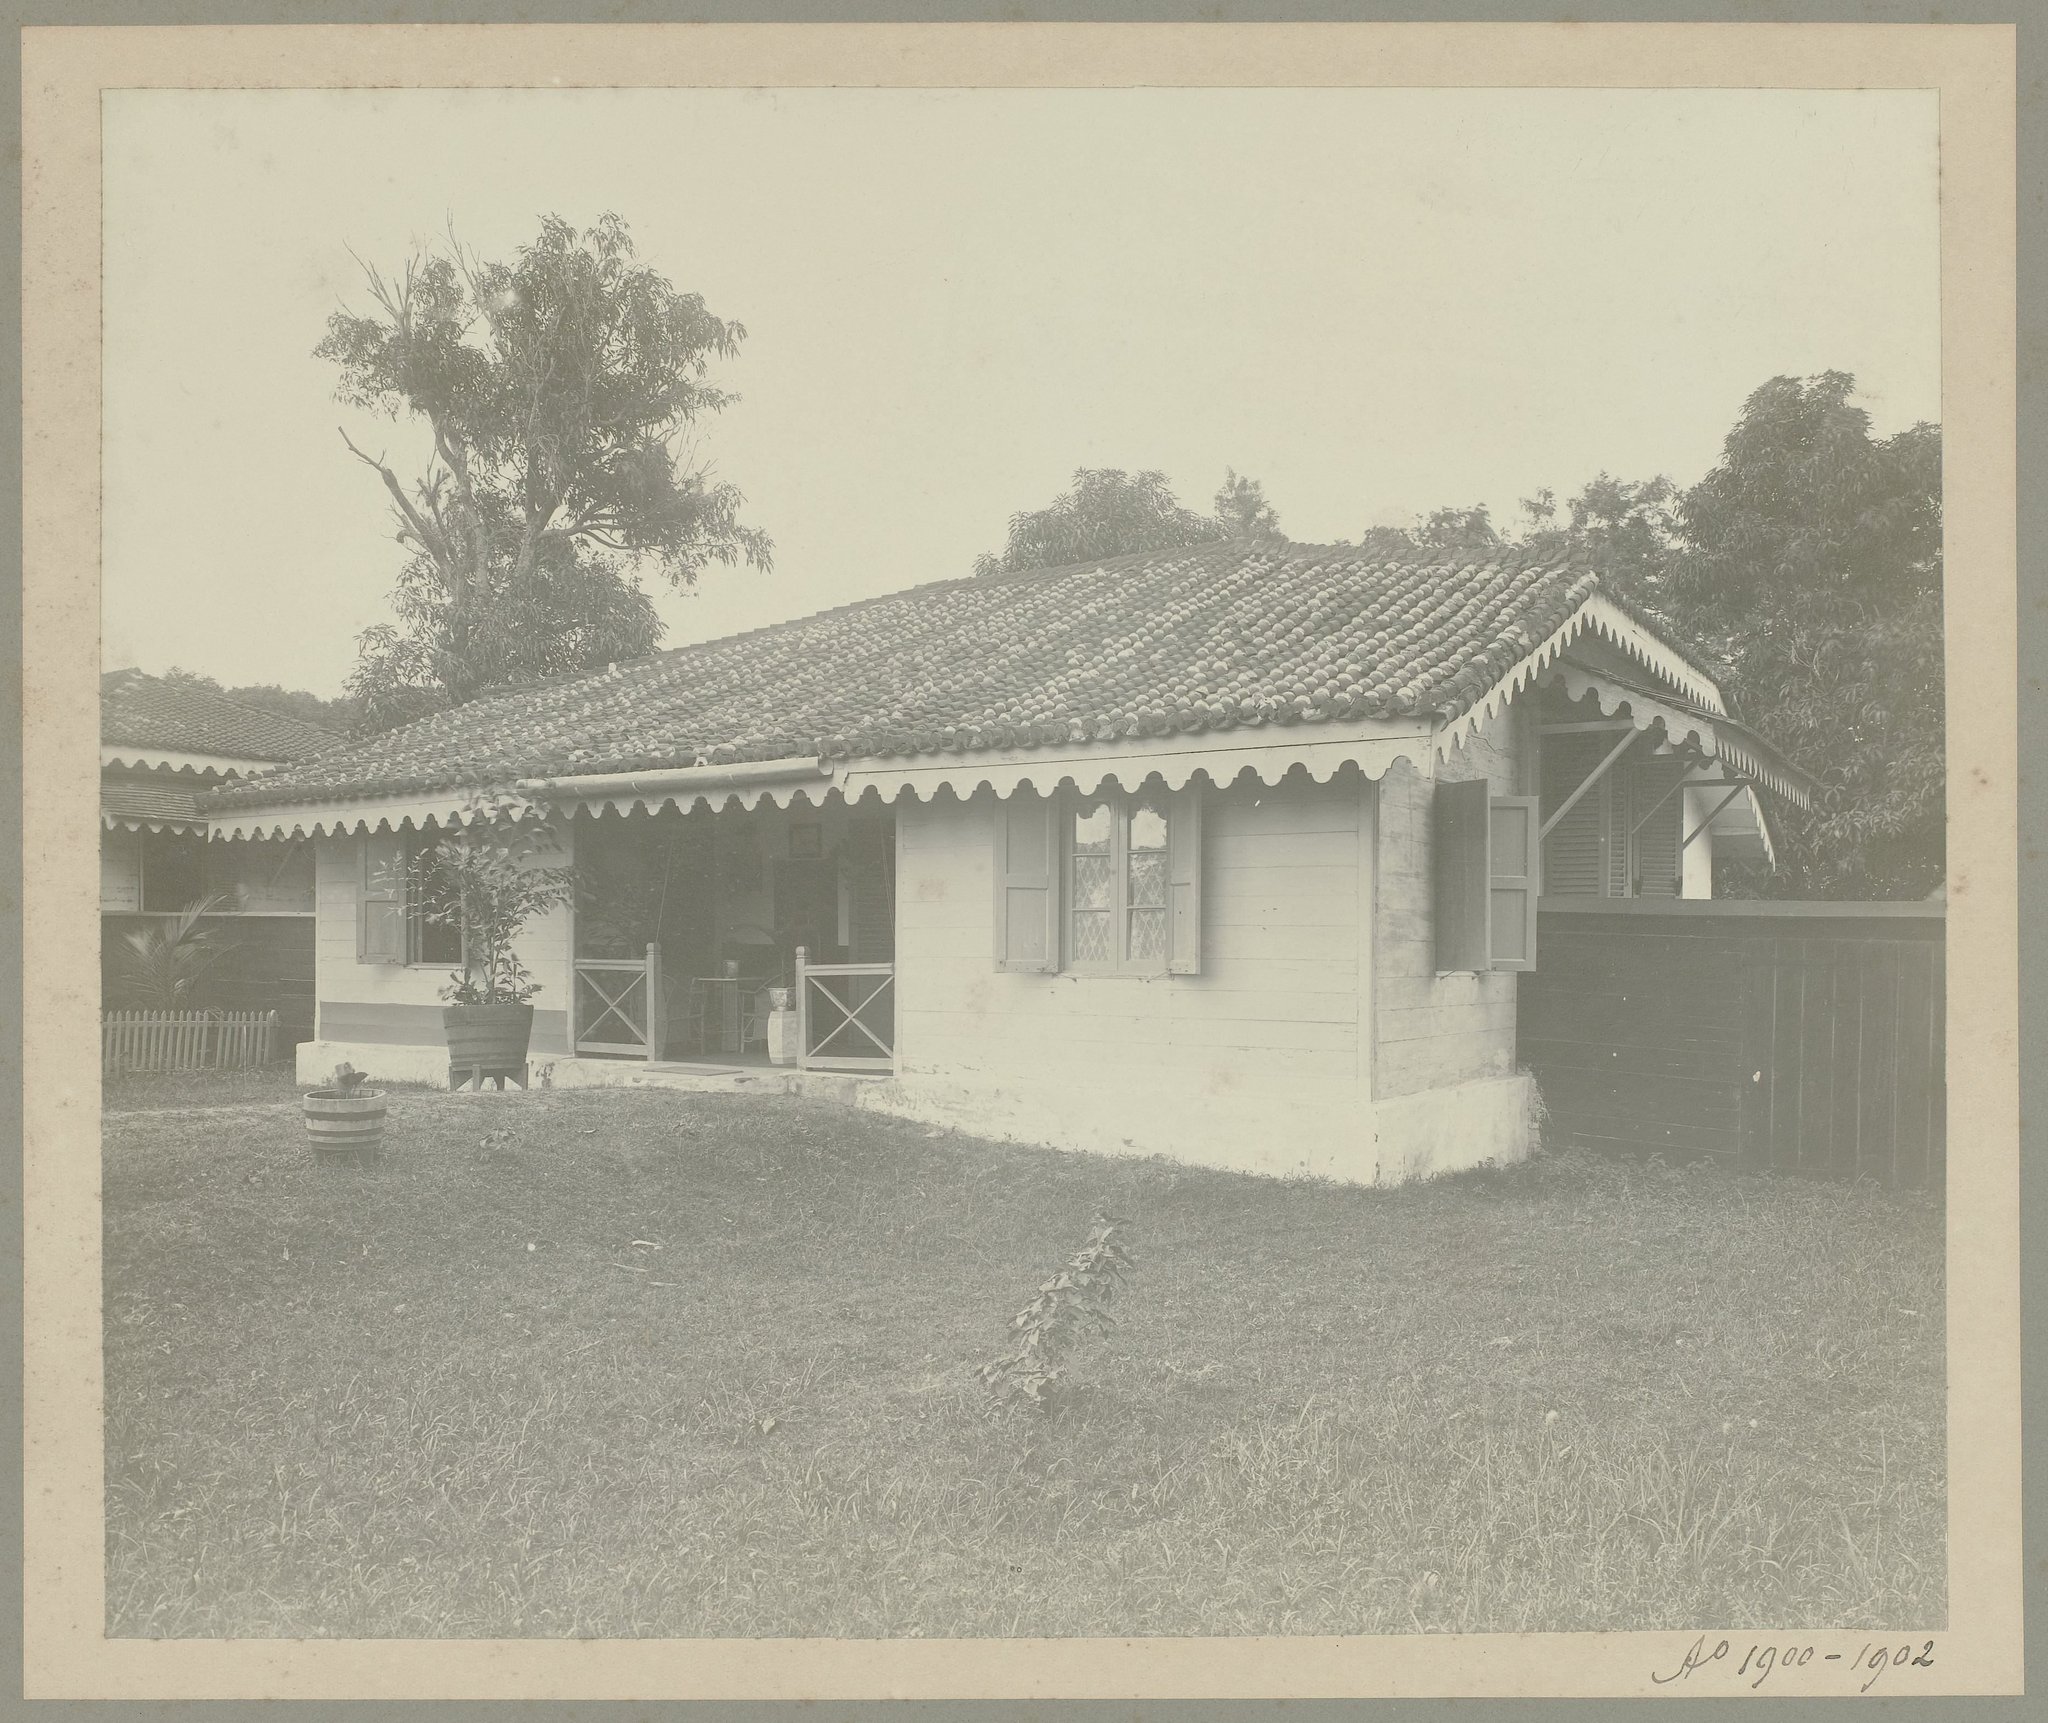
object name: photograph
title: Woonhuis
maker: Anonymous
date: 1900-1902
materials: cardboard, photographic support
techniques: gelatin silver print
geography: banda atjeh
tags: dutch east indies, the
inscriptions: inscription: ‘Ao 1900-1902’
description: Voorzijde van een woonhuis, waarschijnlijk te Banda Atjeh, ca. 1900-1902. Foto opgeplakt op karton. Onderdeel van een groep van negen foto's over de Atjeh-drukkerij.